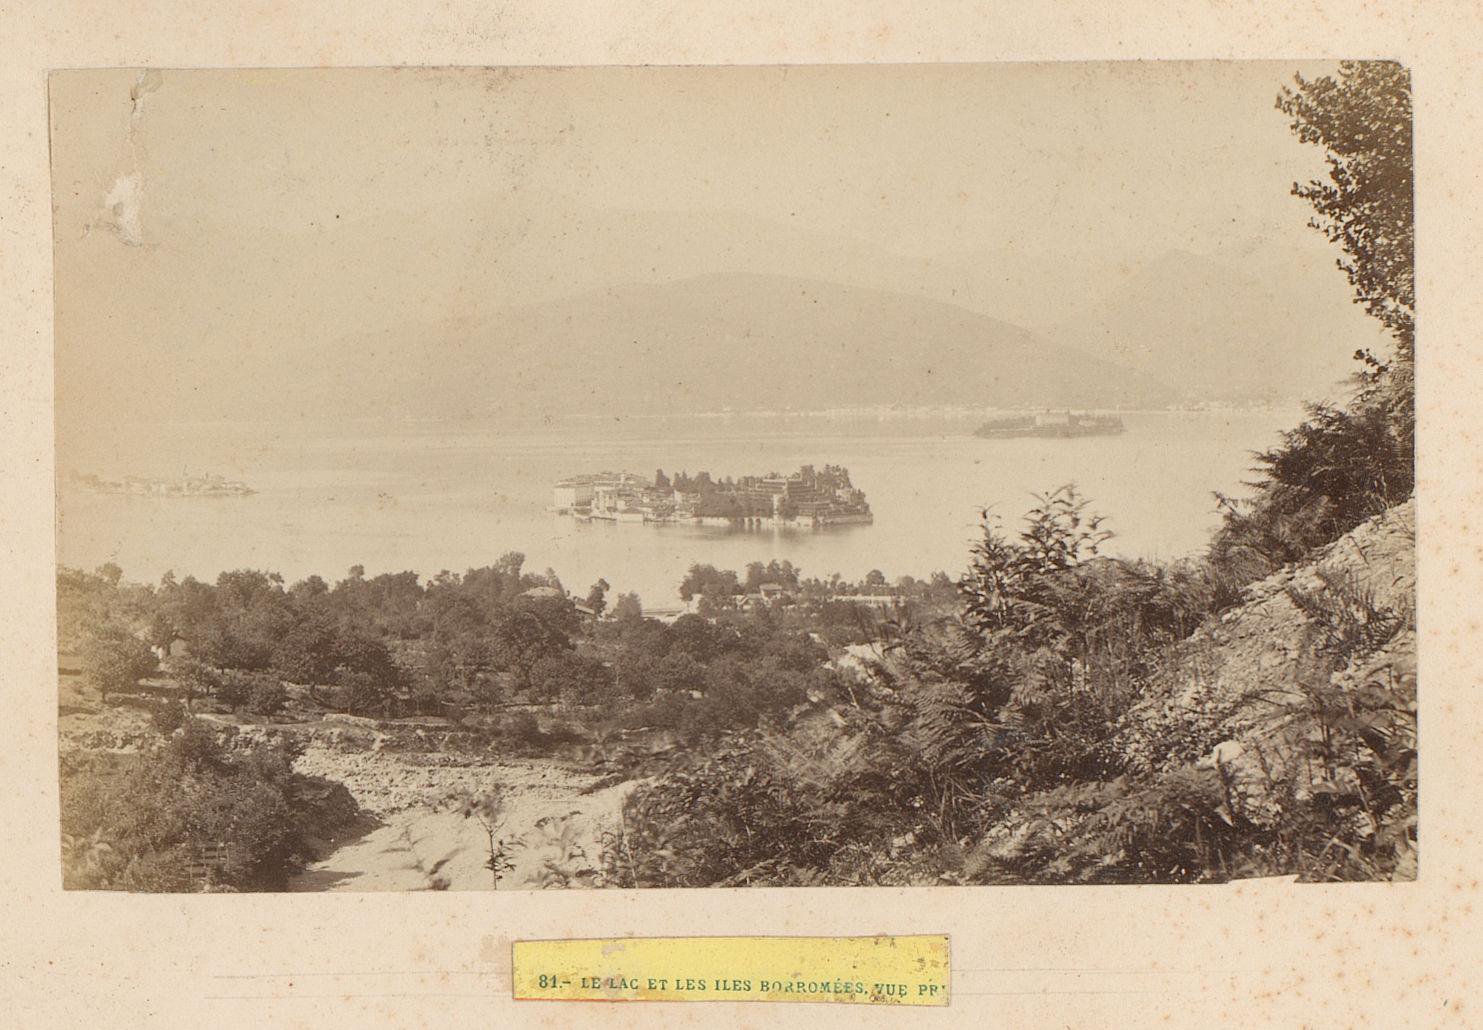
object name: album leaf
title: Le lac et les Iles Borromées vue pris [...]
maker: Anonymous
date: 1860-1890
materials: paper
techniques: albumen print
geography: borromean islands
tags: island, lake